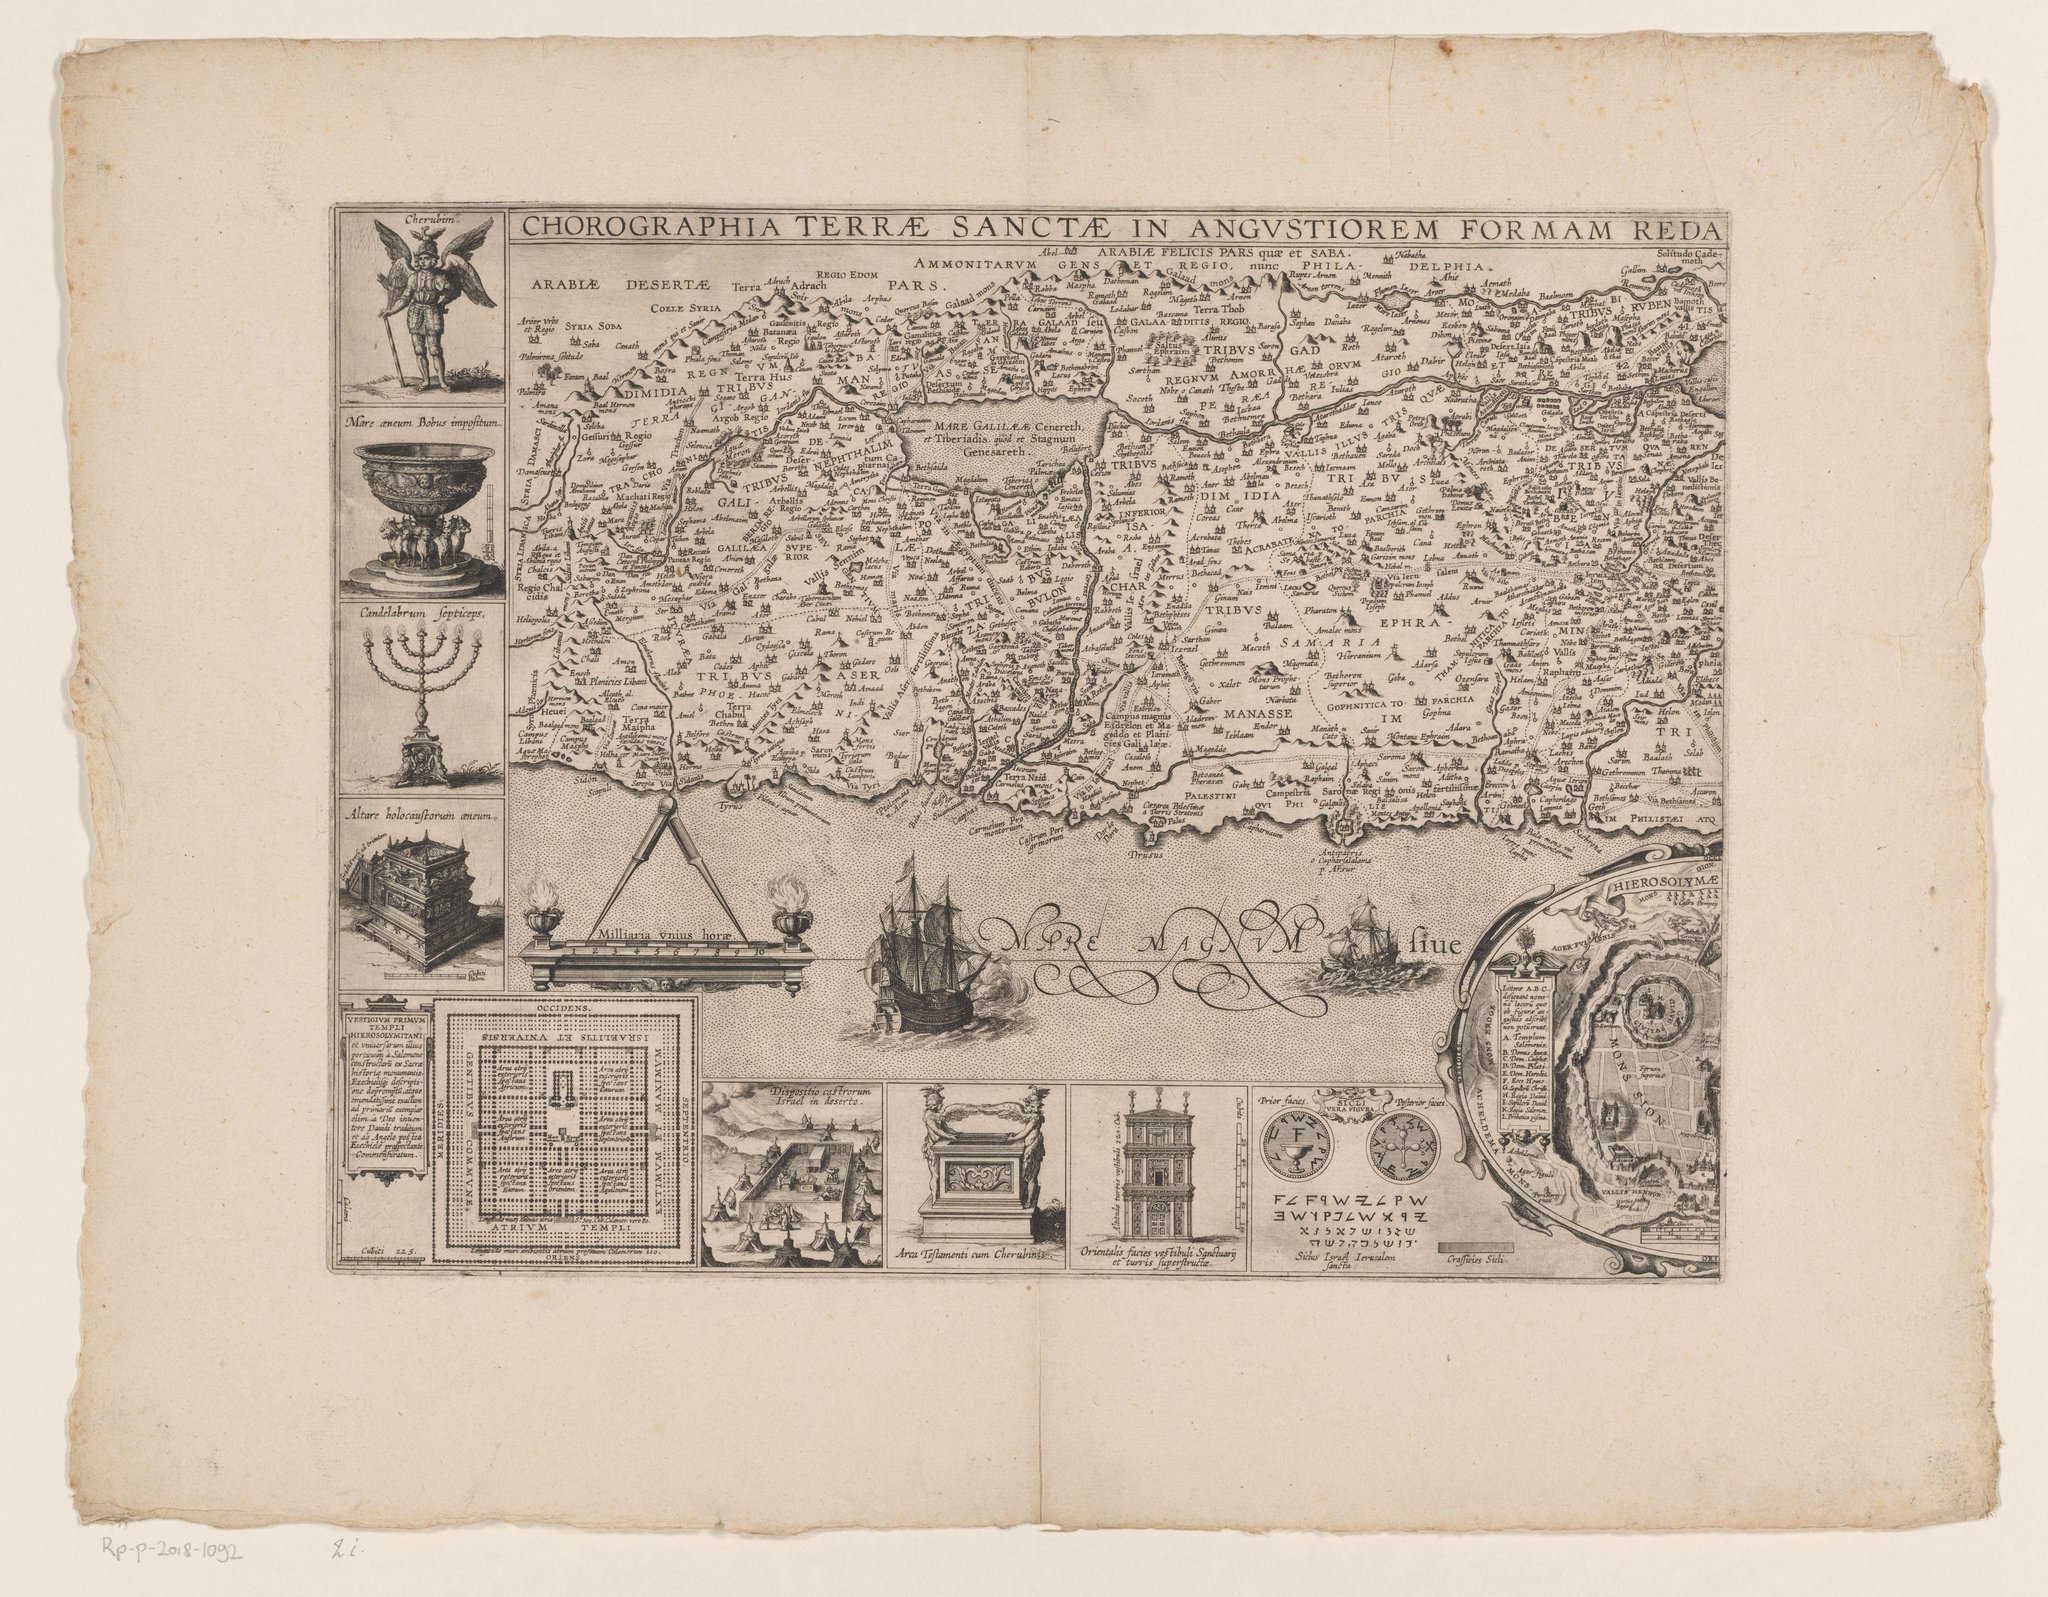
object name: area plan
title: Kaart van het Heilige Land, linkerdeel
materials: paper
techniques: engraving, etching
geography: antwerp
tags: maps of separate countries or regions, the book exodus: story of moses and aaron, maps of cities, the temple (in general) ~ jewish religion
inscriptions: collector's mark: Lugt 2228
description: Prent ook gebruikt in: Tirinus, Jacobus. Commentarius in Vetus et Novum Testamentum. Antwerpen: Martiuns Nutius (III), 1632.